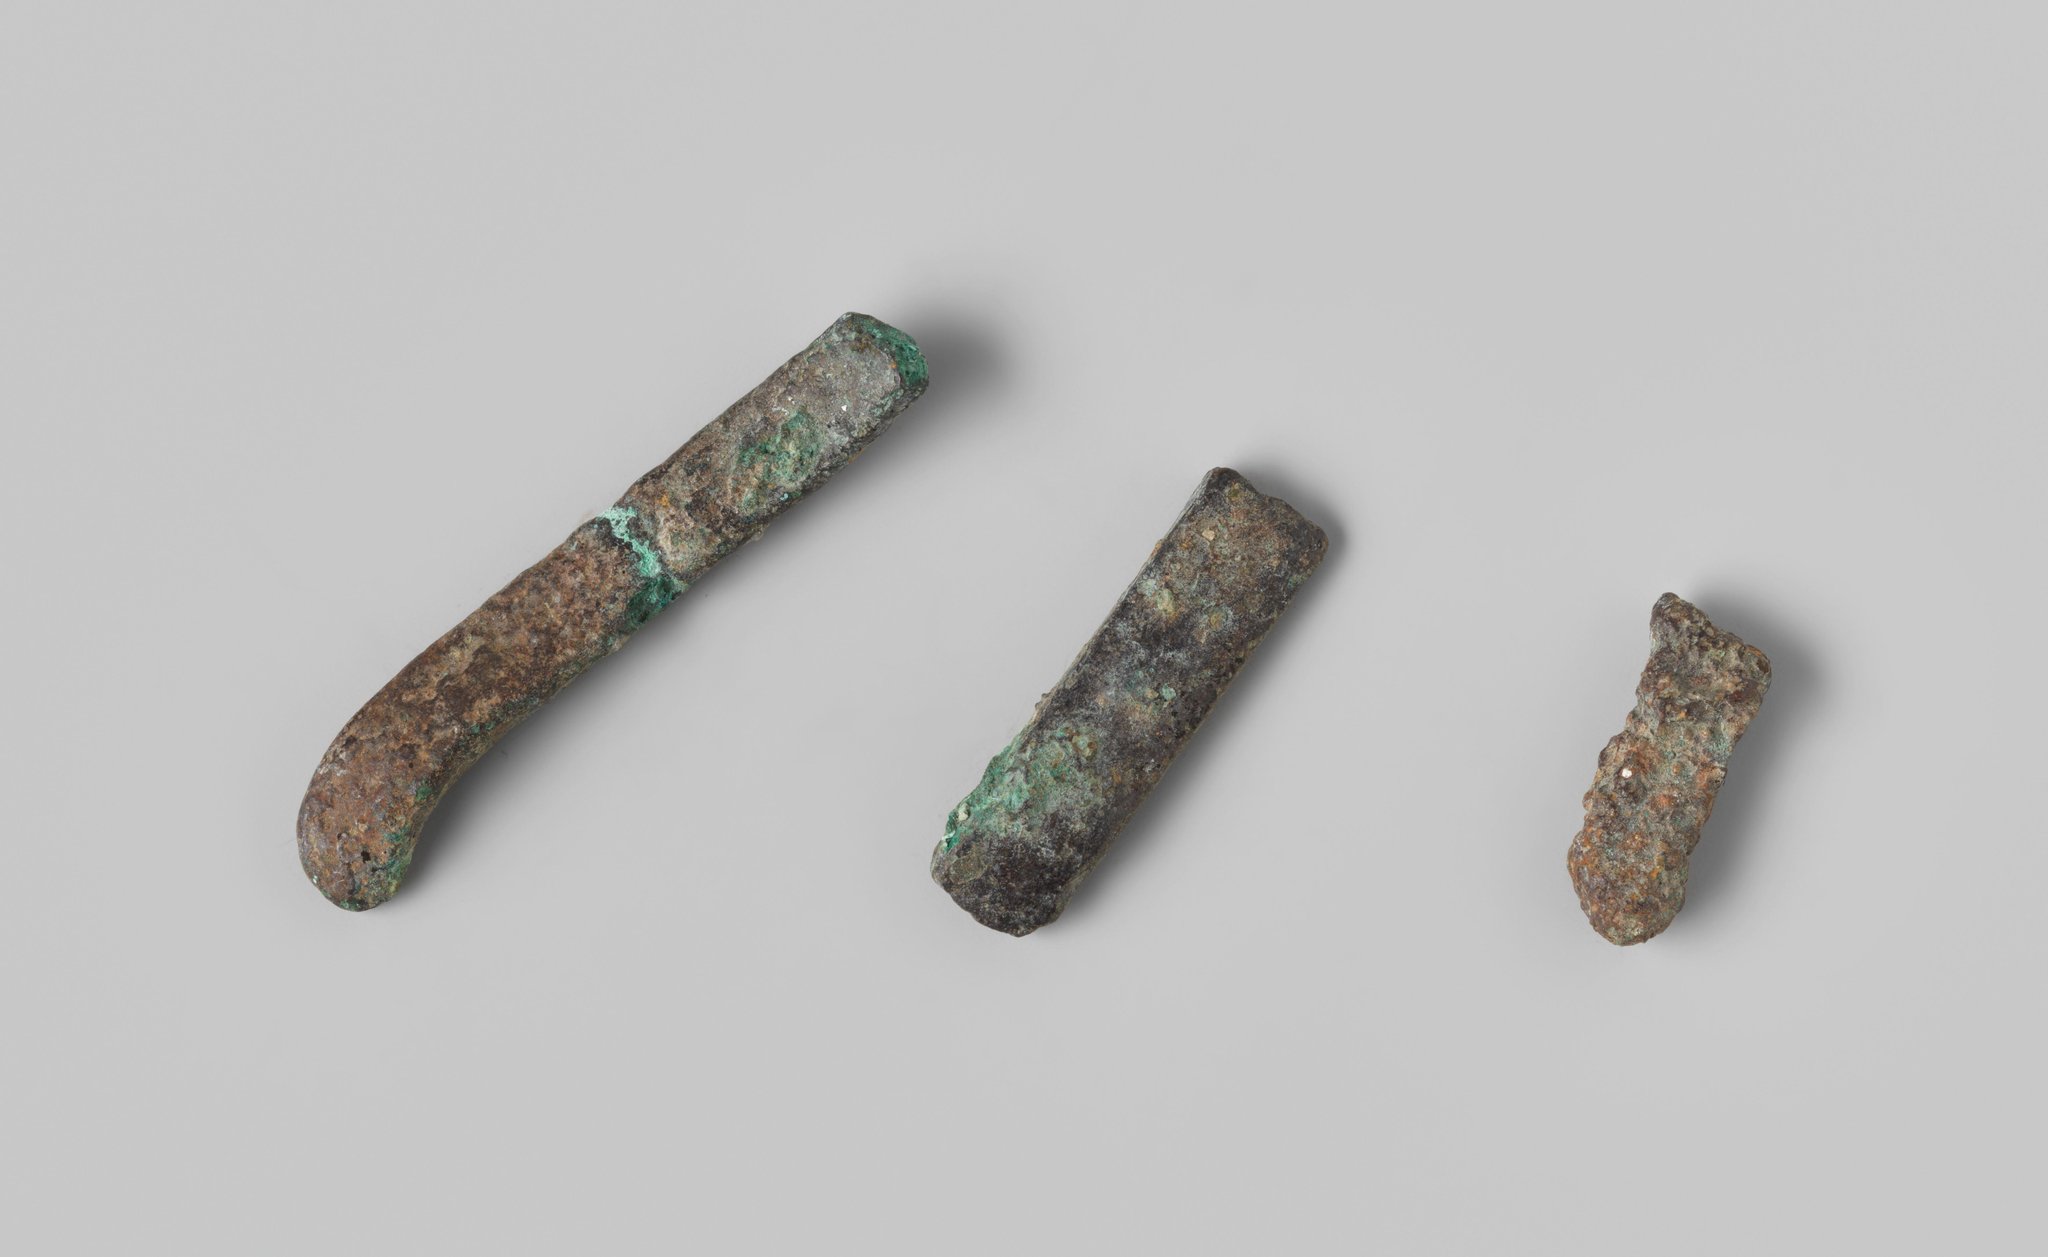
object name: belt buckle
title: Fragmenten riemgesp uit het wrak van de Oost-Indiëvaarder Hollandia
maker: Anonymous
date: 1700-1743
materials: copper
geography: netherlands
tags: verenigde oostindische compagnie, hollandia (schip), annet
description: Rectangular, fragm of rings, id. NG 1980-27H2796, belt buckle.